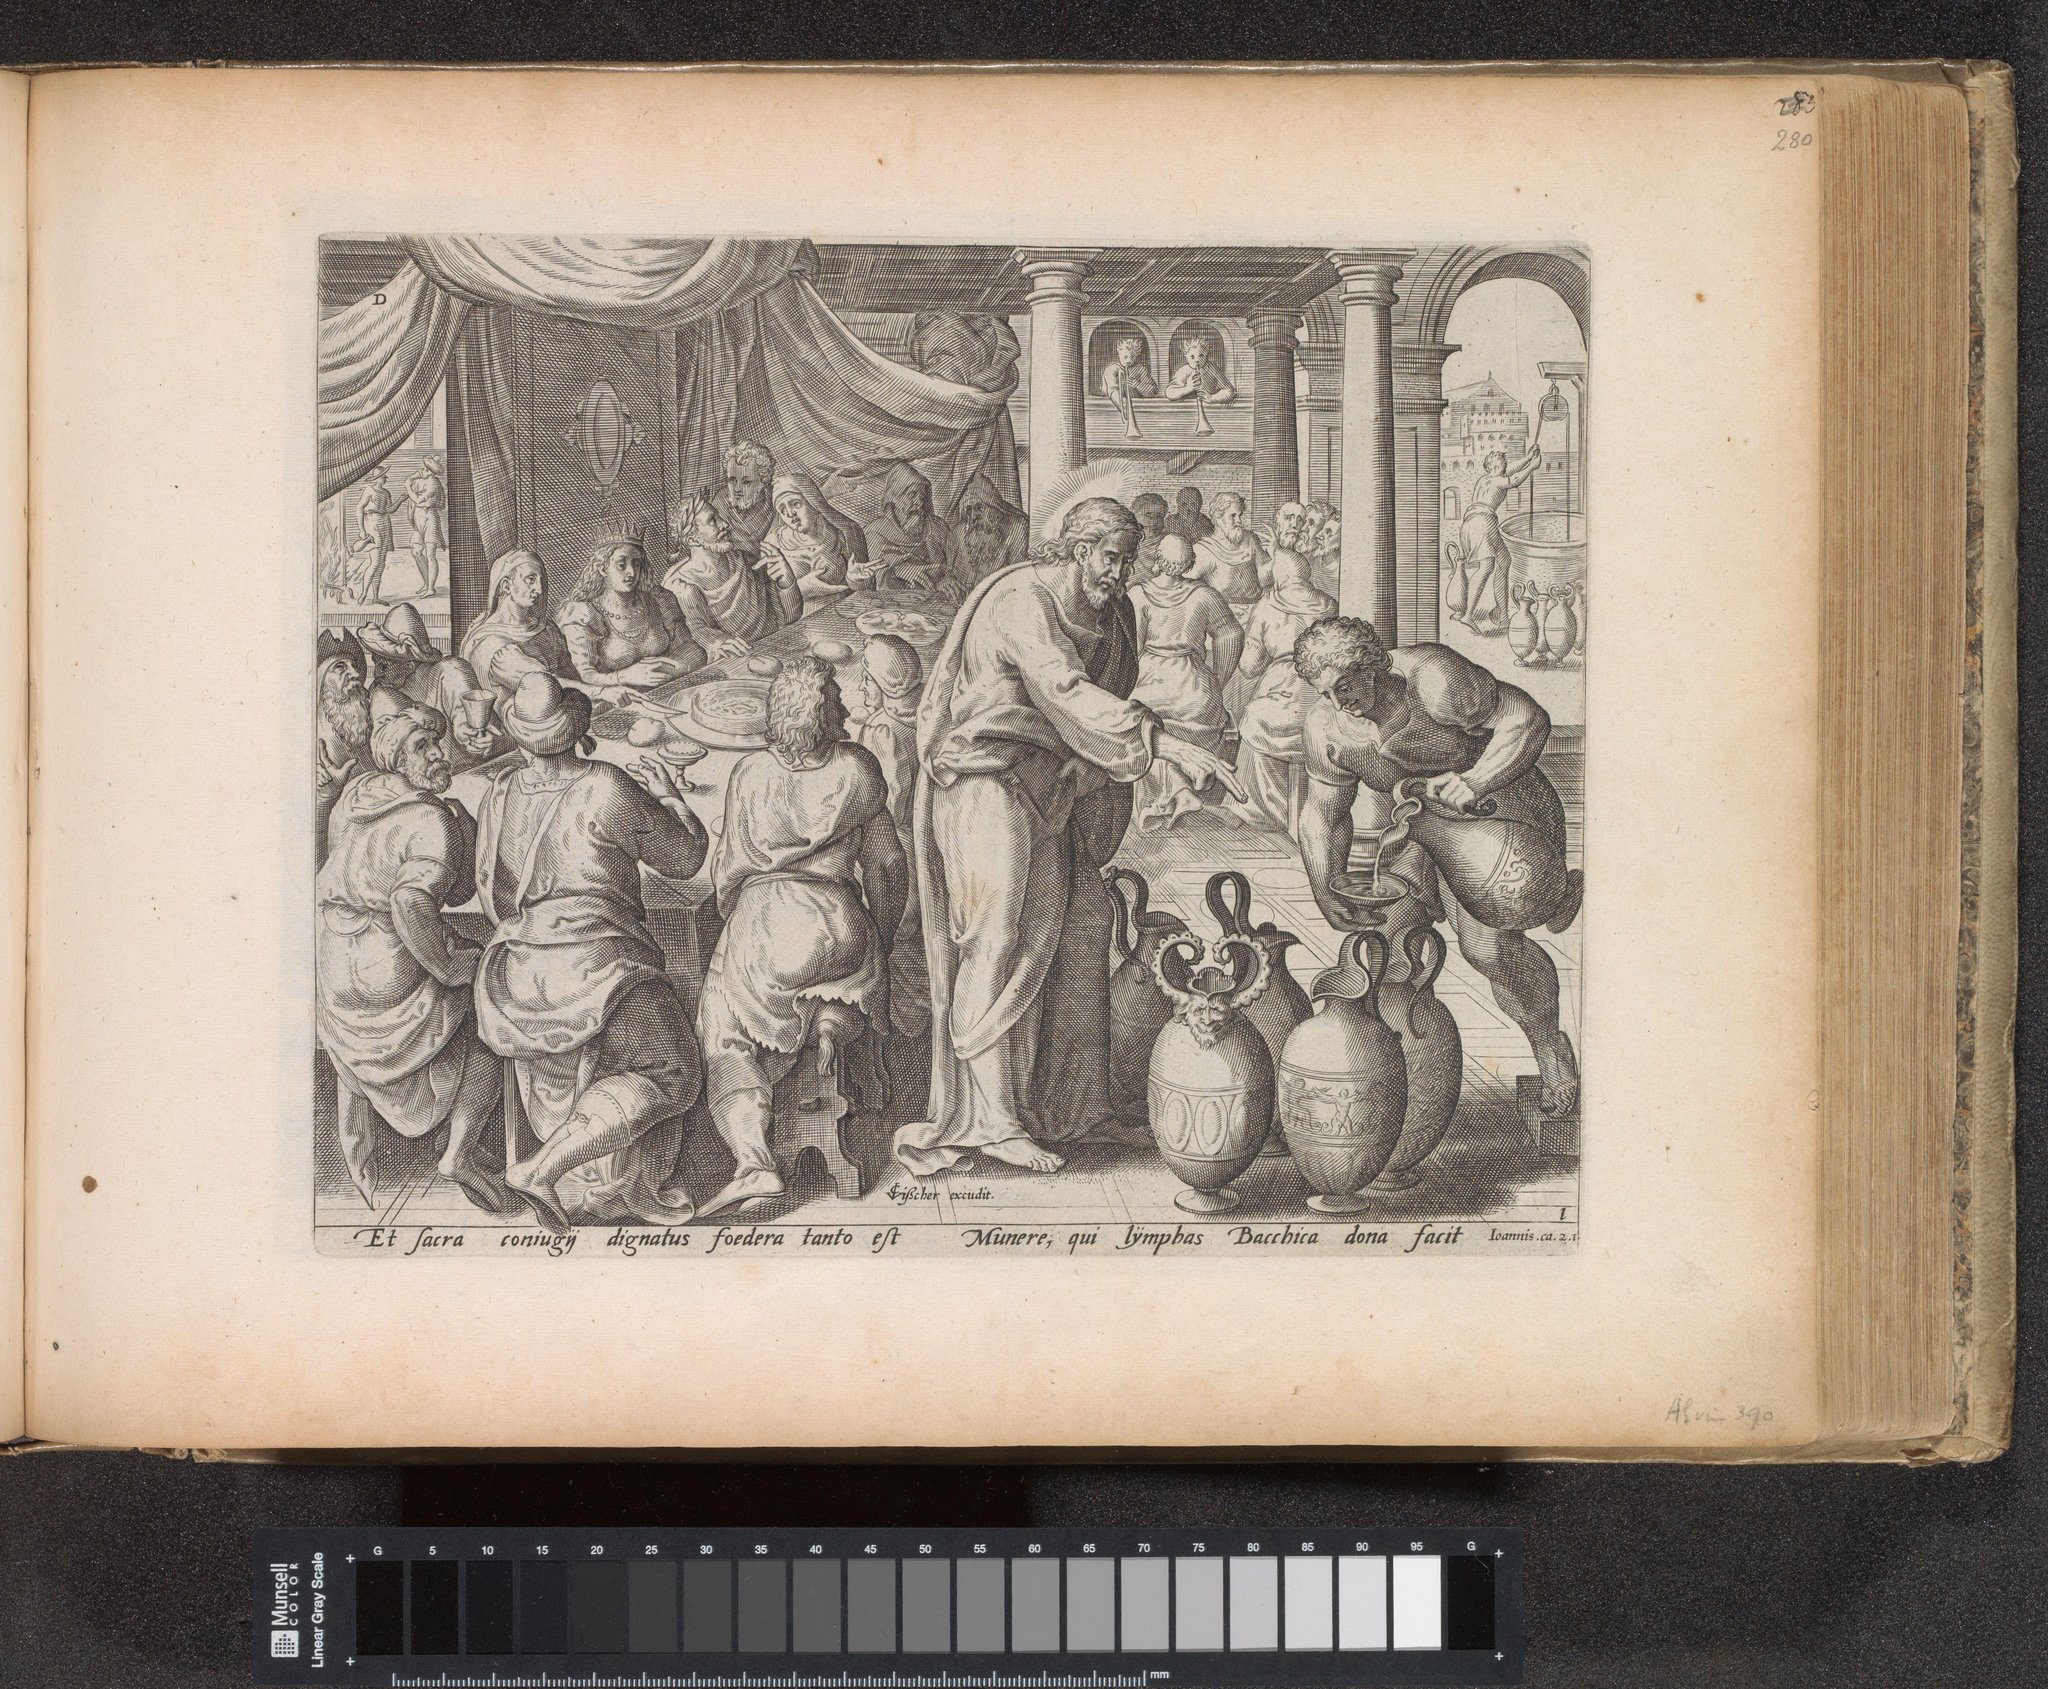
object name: print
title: Wonderen van Christus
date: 1572-1576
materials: paper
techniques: engraving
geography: amsterdam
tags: the marriage-feast at cana (john 2:1-11)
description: Christus geeft op de bruiloft te Kana opdracht om kruiken met water te vullen. Het bruidspaar en de gasten zitten aan tafel. Maria zit links achter aan tafel. Links op de achtergrond proeft de ceremoniemeester van het water dat veranderd is in wijn. Onder de voorstelling een verwijzing in het Latijn naar de Bijbeltekst in Joh. 2:1. Deze prent maakt deel uit van een album.